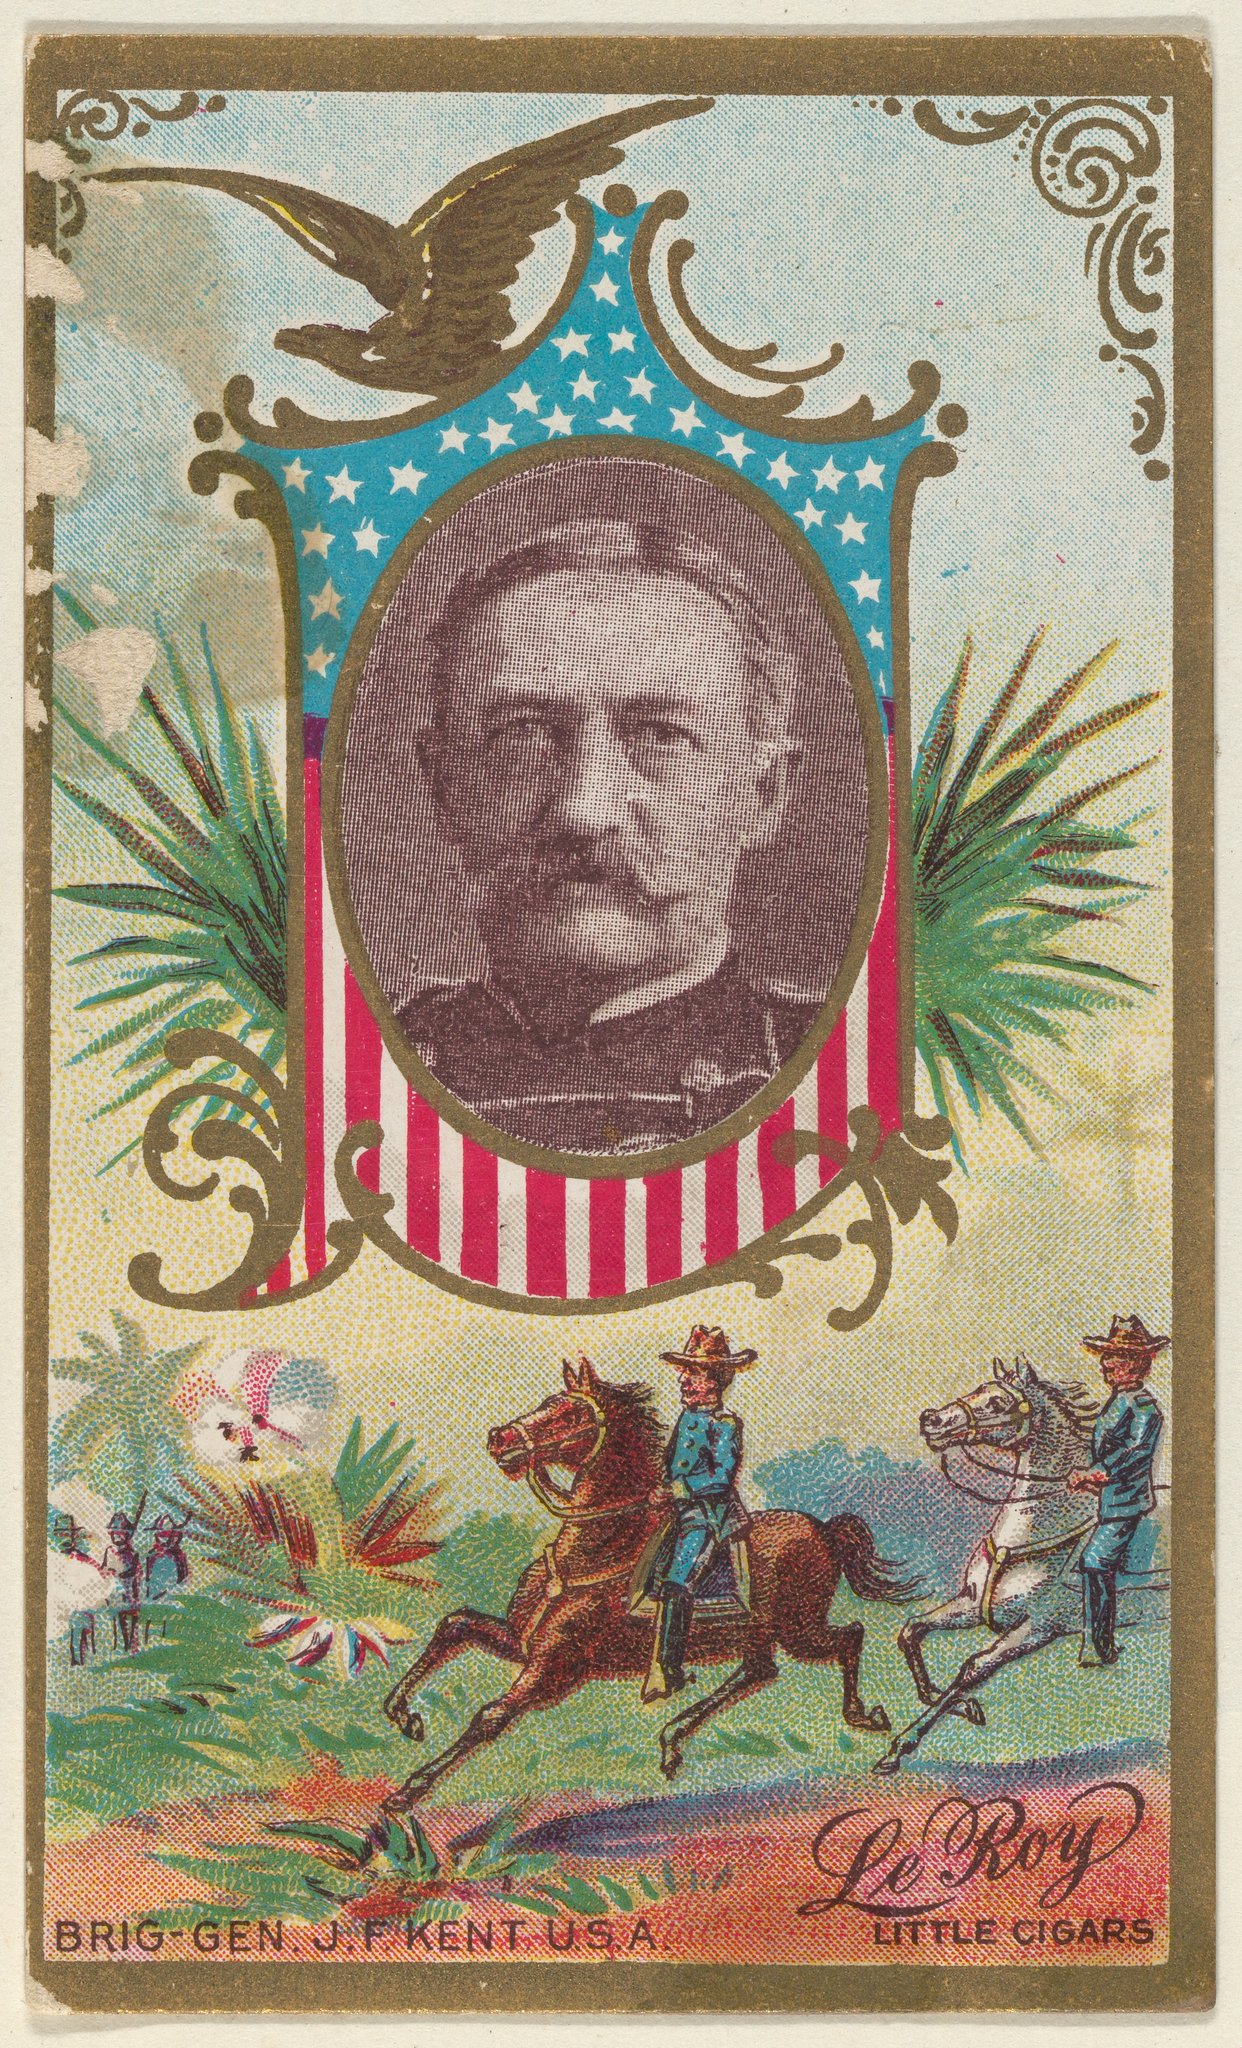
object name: print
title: Brigadier General Jacob F. Kent, U.S. Army, from the "Generals" series (T63), issued by LeRoy Little Cigars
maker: leroy little cigars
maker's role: publisher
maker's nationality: american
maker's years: 1850-1950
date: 1898-1901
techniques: color lithograph